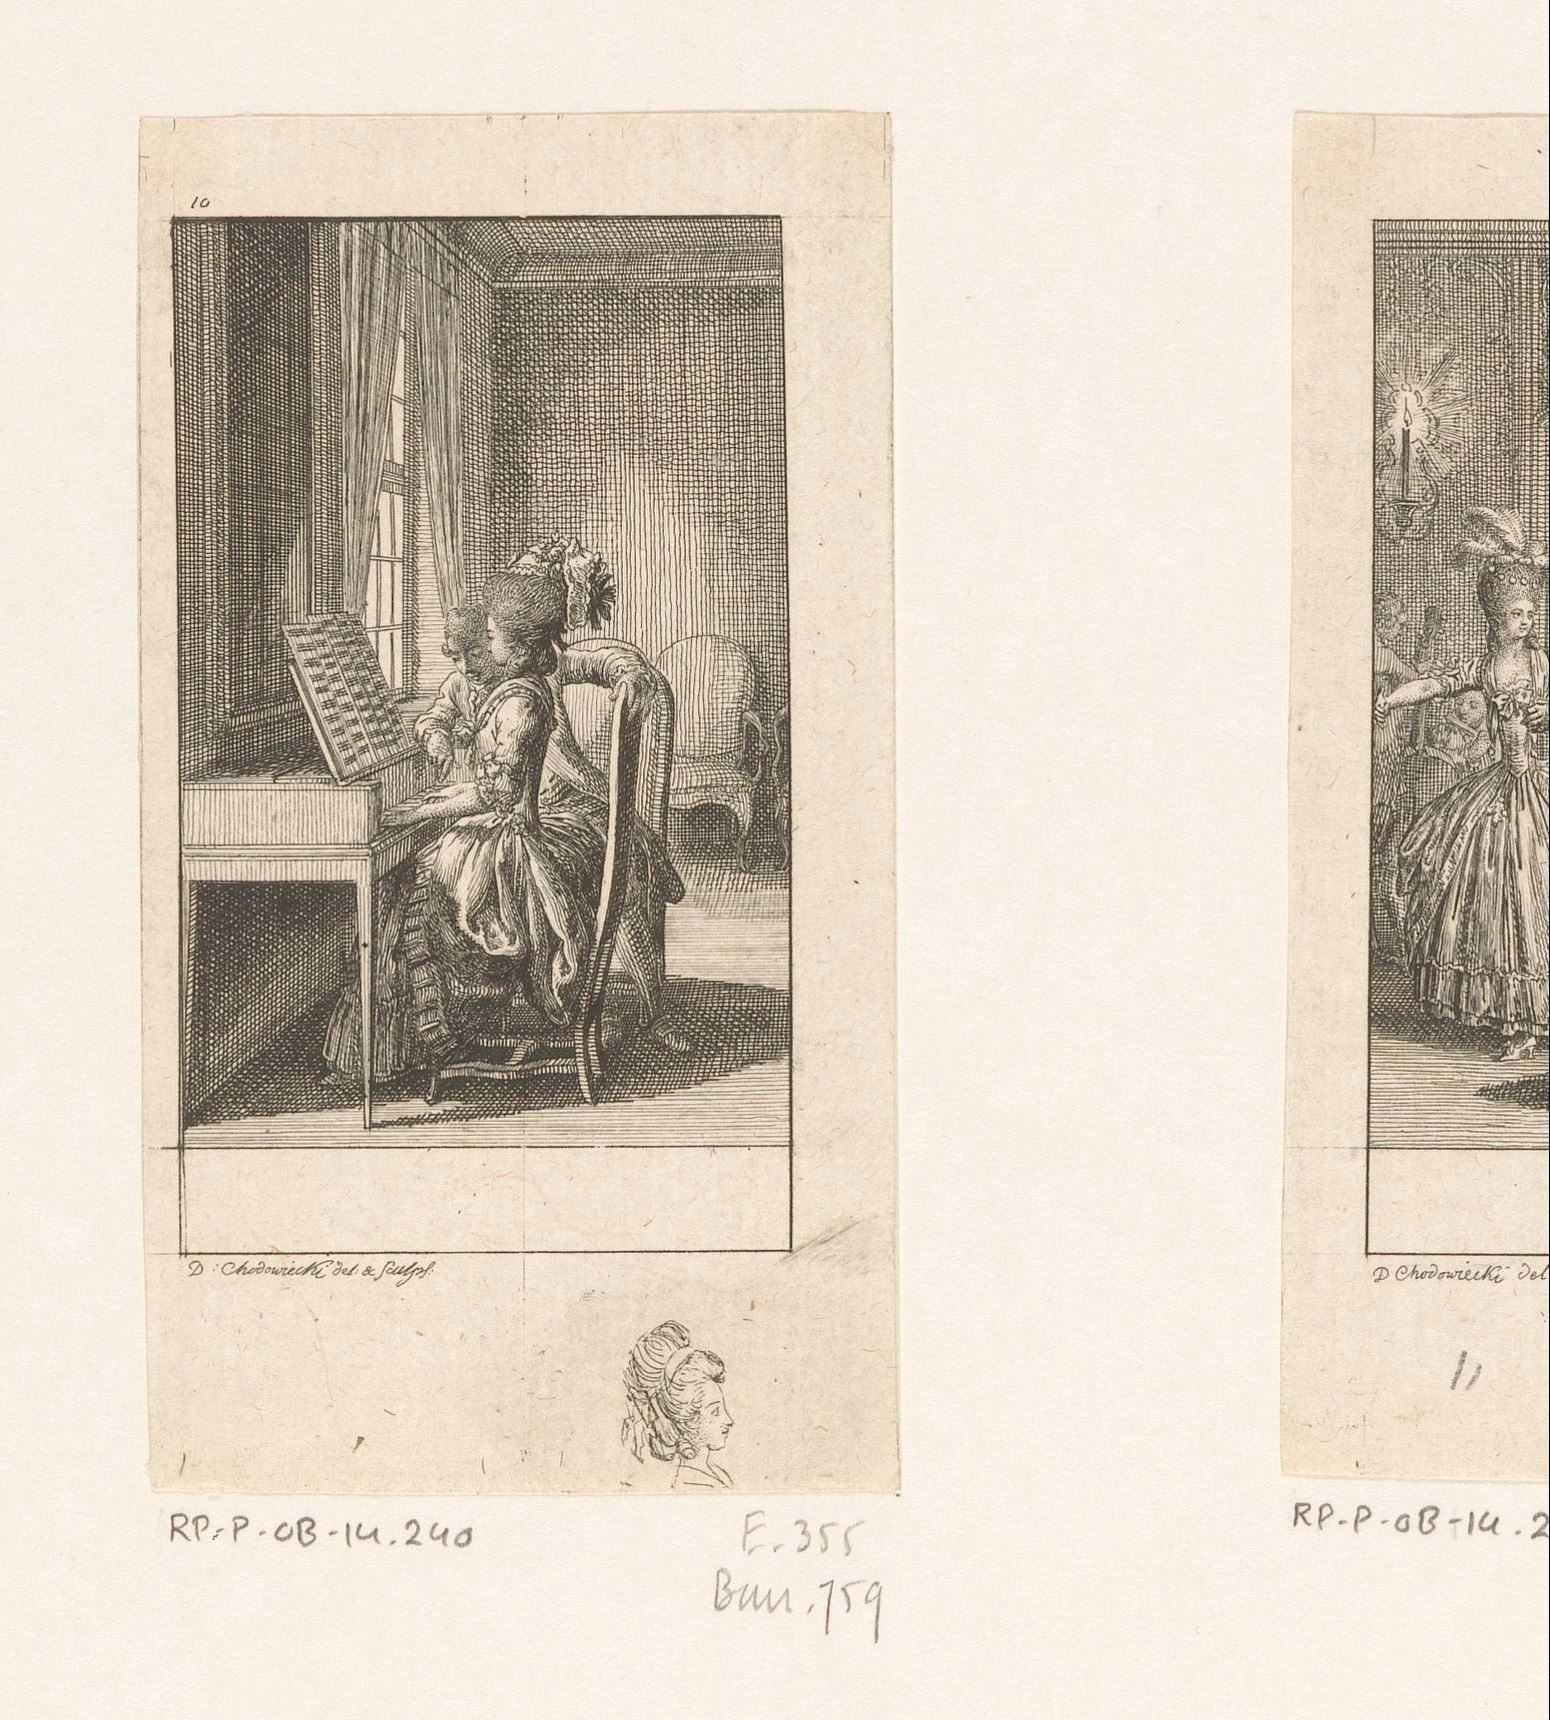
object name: print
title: Muziekles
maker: daniel nikolaus chodowiecki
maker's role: draughtsman, print maker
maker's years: 1726-1801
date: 1780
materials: paper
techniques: etching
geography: berlin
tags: musician training pupils, music-lesson, keyboard instruments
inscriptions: collector's mark: Lugt 2228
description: Prent gebruikt voor: Almanac Généalogique pour l'année 1781 (...). S.l.s.n., [1780]. Een serie van twaalf prenten betreffende bezigheden voor dames.